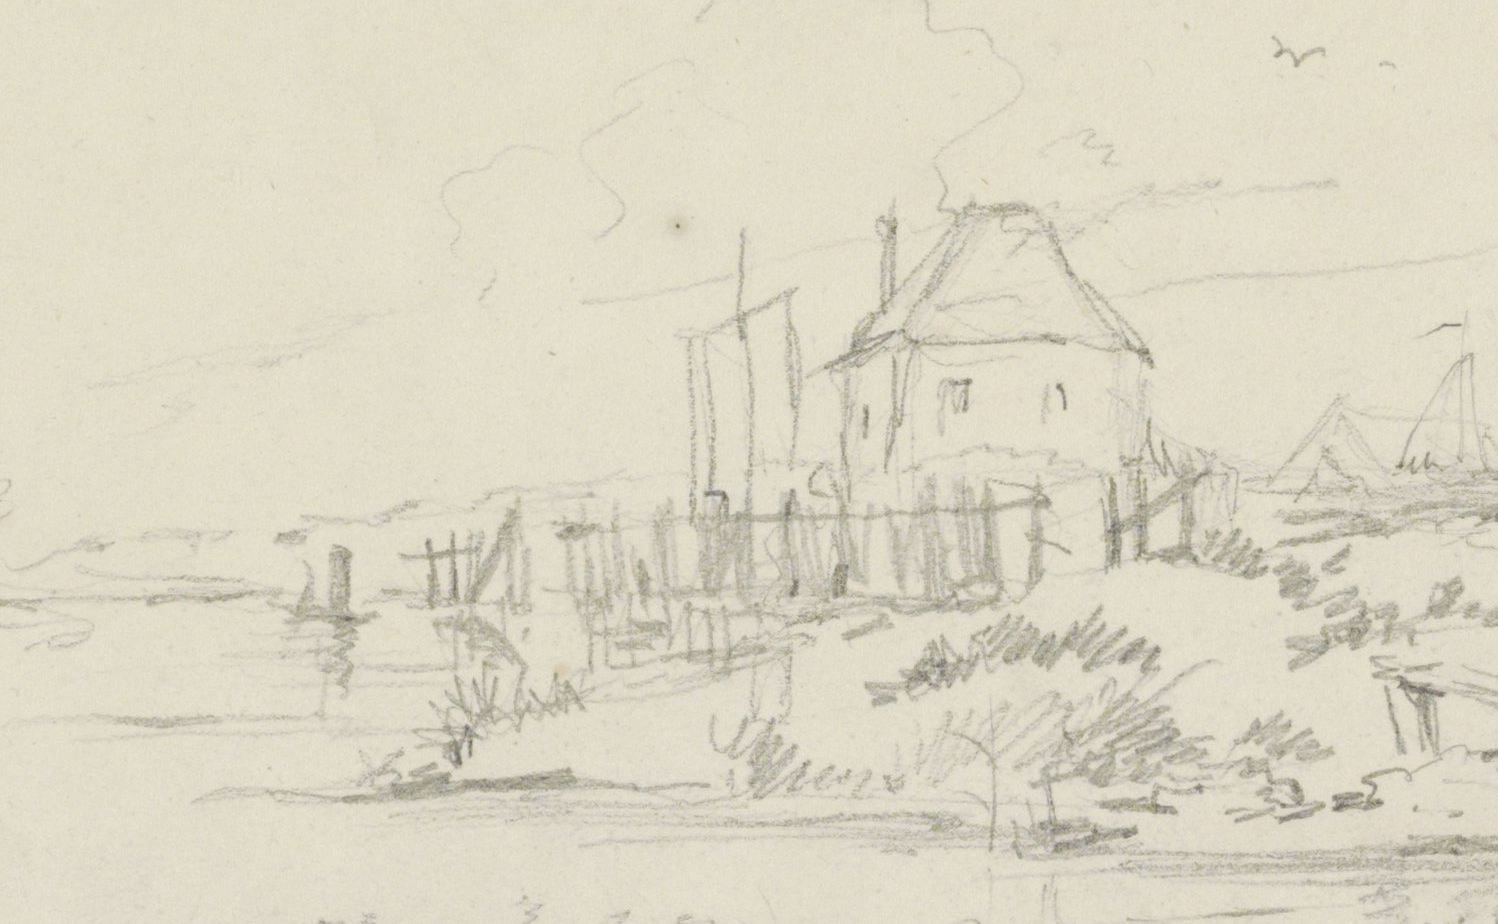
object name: sketchbook leaf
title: Rivierlandschap met een molen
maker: adrianus eversen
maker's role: draughtsman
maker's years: 1818-1897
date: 1828-1897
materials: paper, pencil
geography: netherlands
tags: sailing-ship, sailing-boat, river, rural housing, e.g. country-house, villa, cottage, windmill in landscape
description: Rivierlandschap. Rechts op de oever een gebouw en links een molen. In de verte zeilschepen. Blad 22 recto uit een schetsboek met 27 bladen.